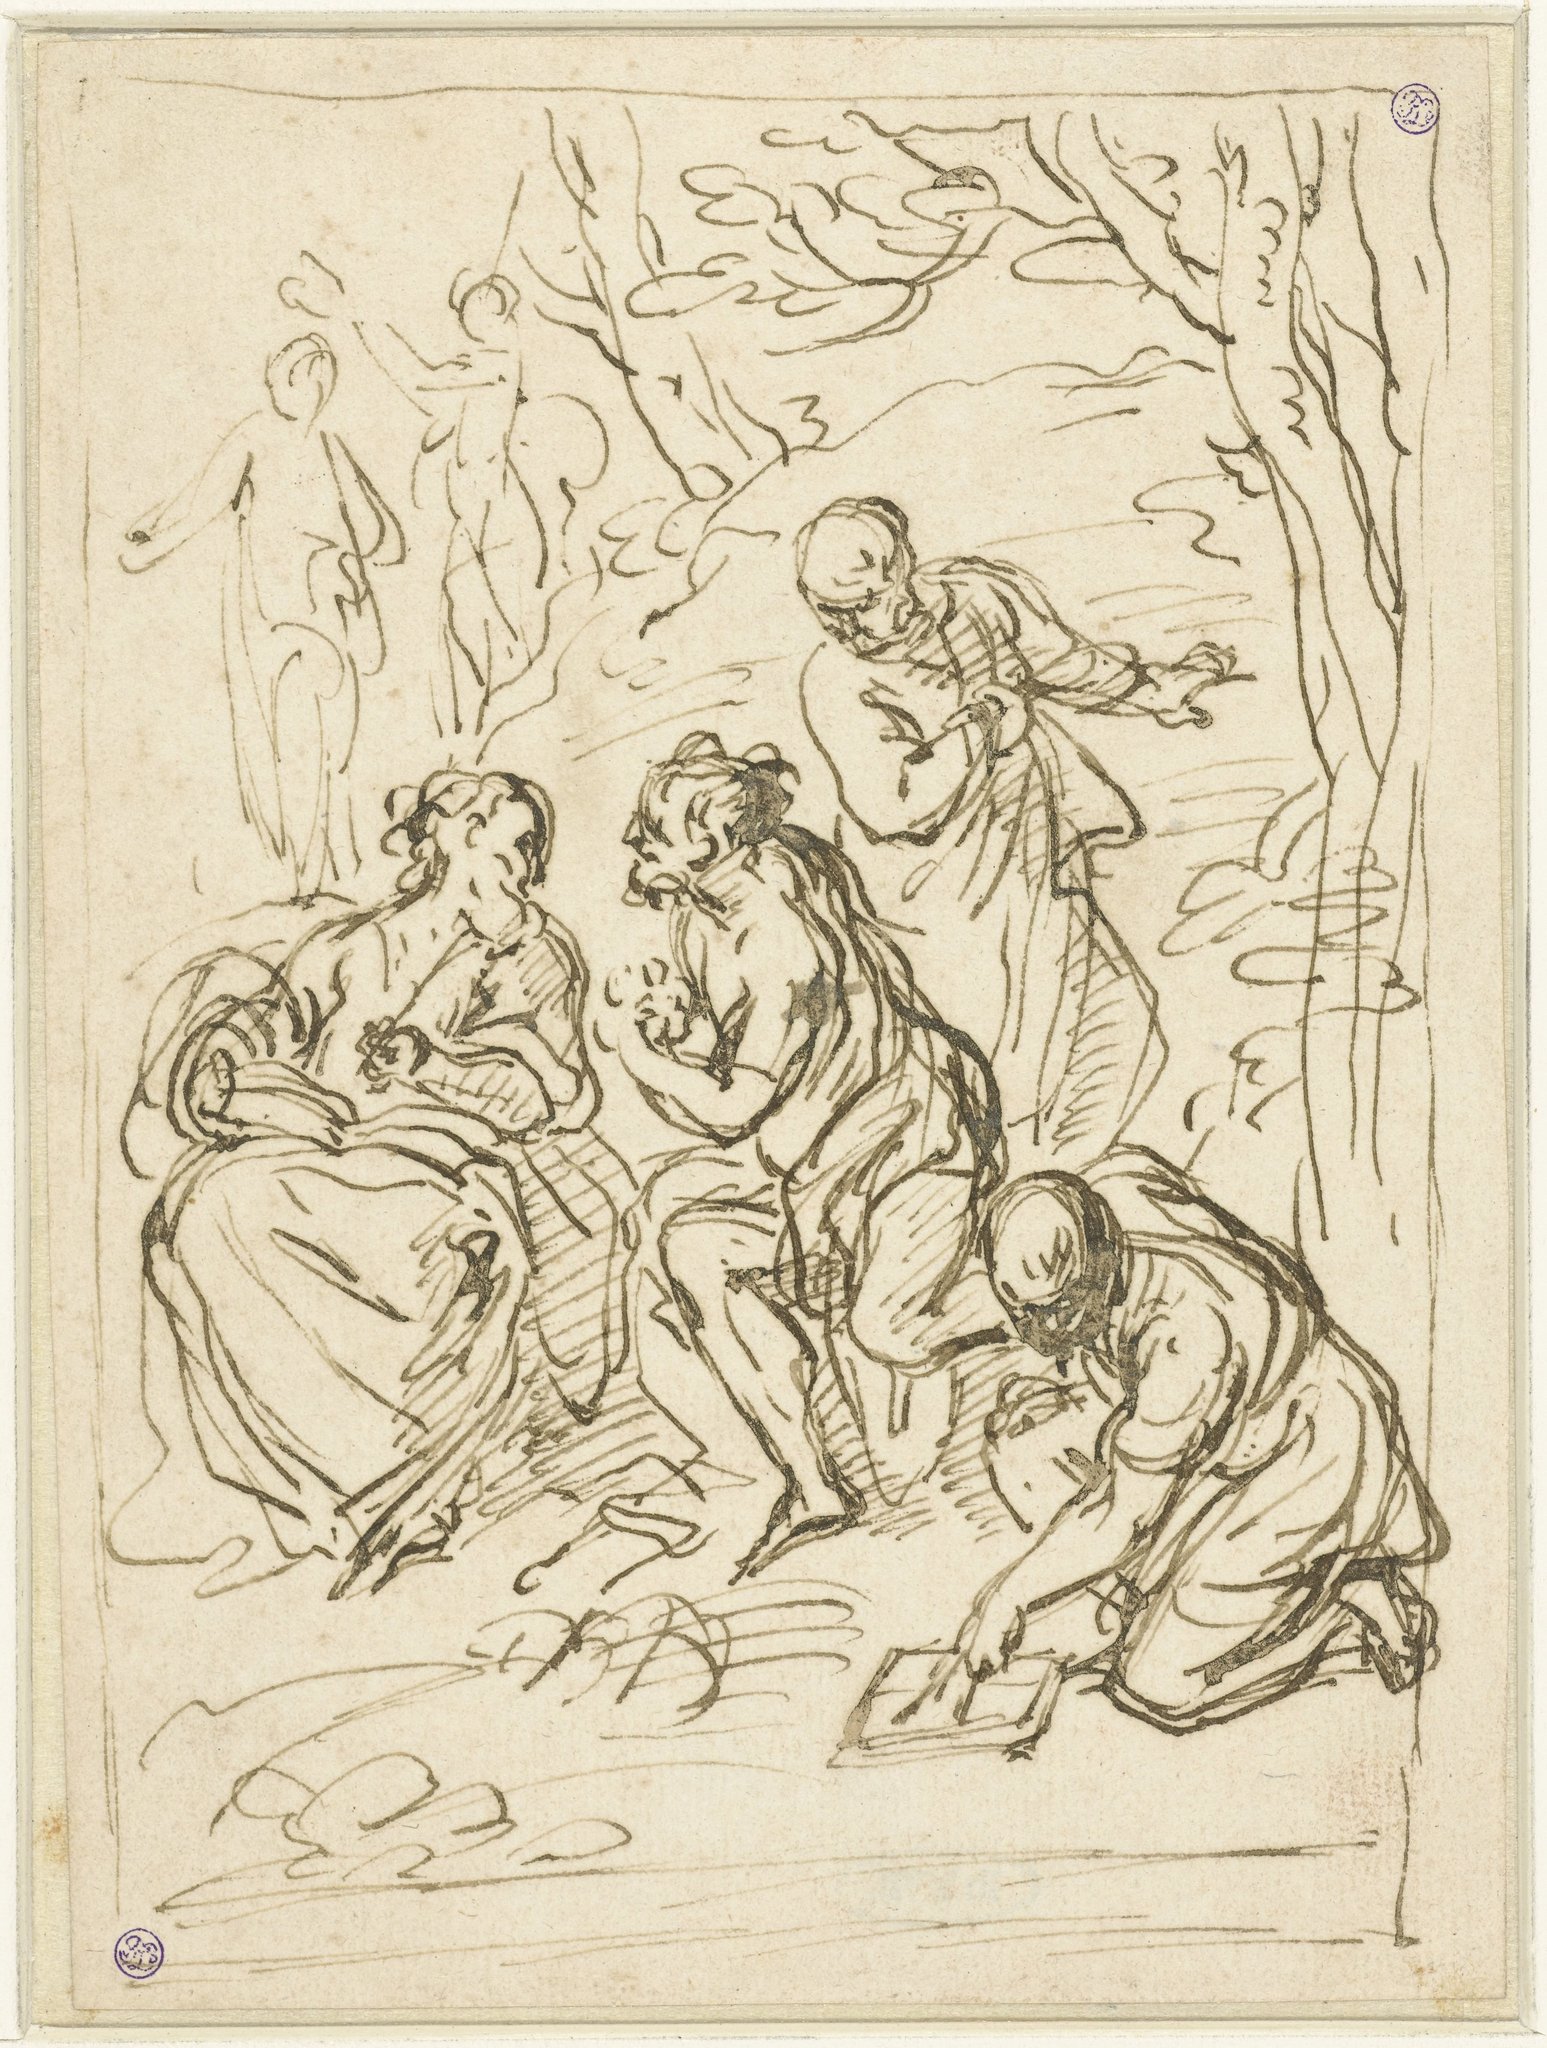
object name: drawing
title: Mythologische of allegorische voorstelling met zes figuren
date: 1600-1699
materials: ink, paper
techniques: pen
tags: sitting figure - aa - female human figure, kneeling figure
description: Op de voorgrond zijn vier figuren te zien naast een boom, op de achtergrond twee figuren.